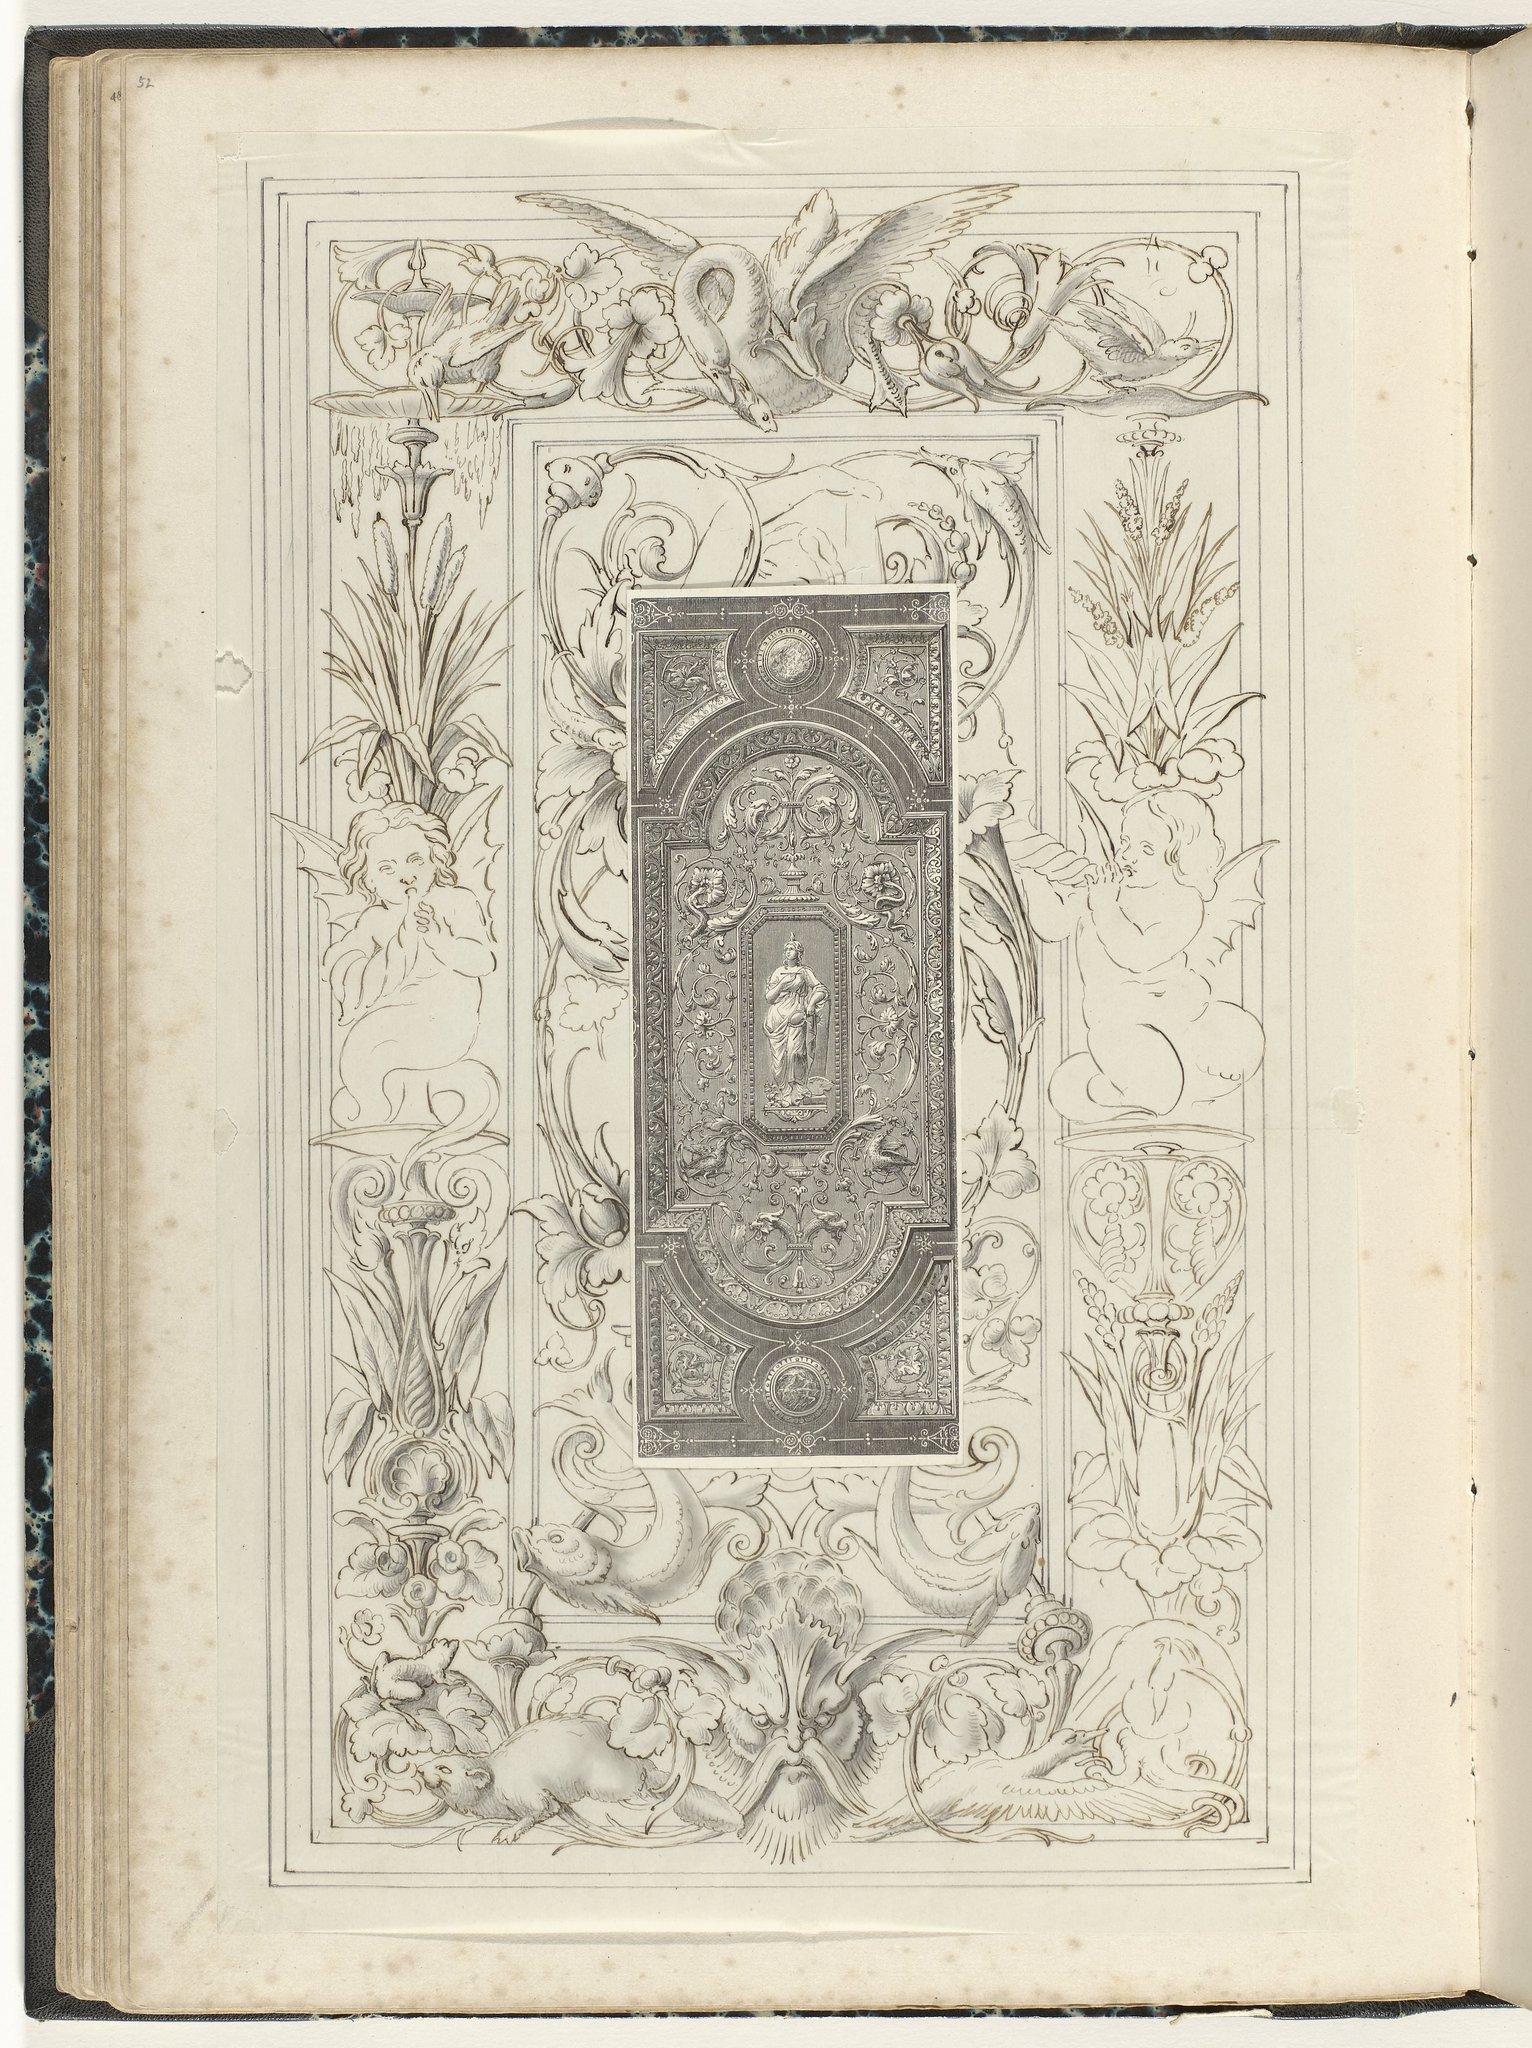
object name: print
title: Klein paneel op groot paneel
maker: Anonymous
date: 1866-1900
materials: paper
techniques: drawing, engraving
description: Klein paneel met figuur in het midden, geplakt op een groter paneel met planten, dieren en twee gevleugelde putti die links en rechts op een schelp blazen. Het onderlijf van de putti loopt uit in een staart.